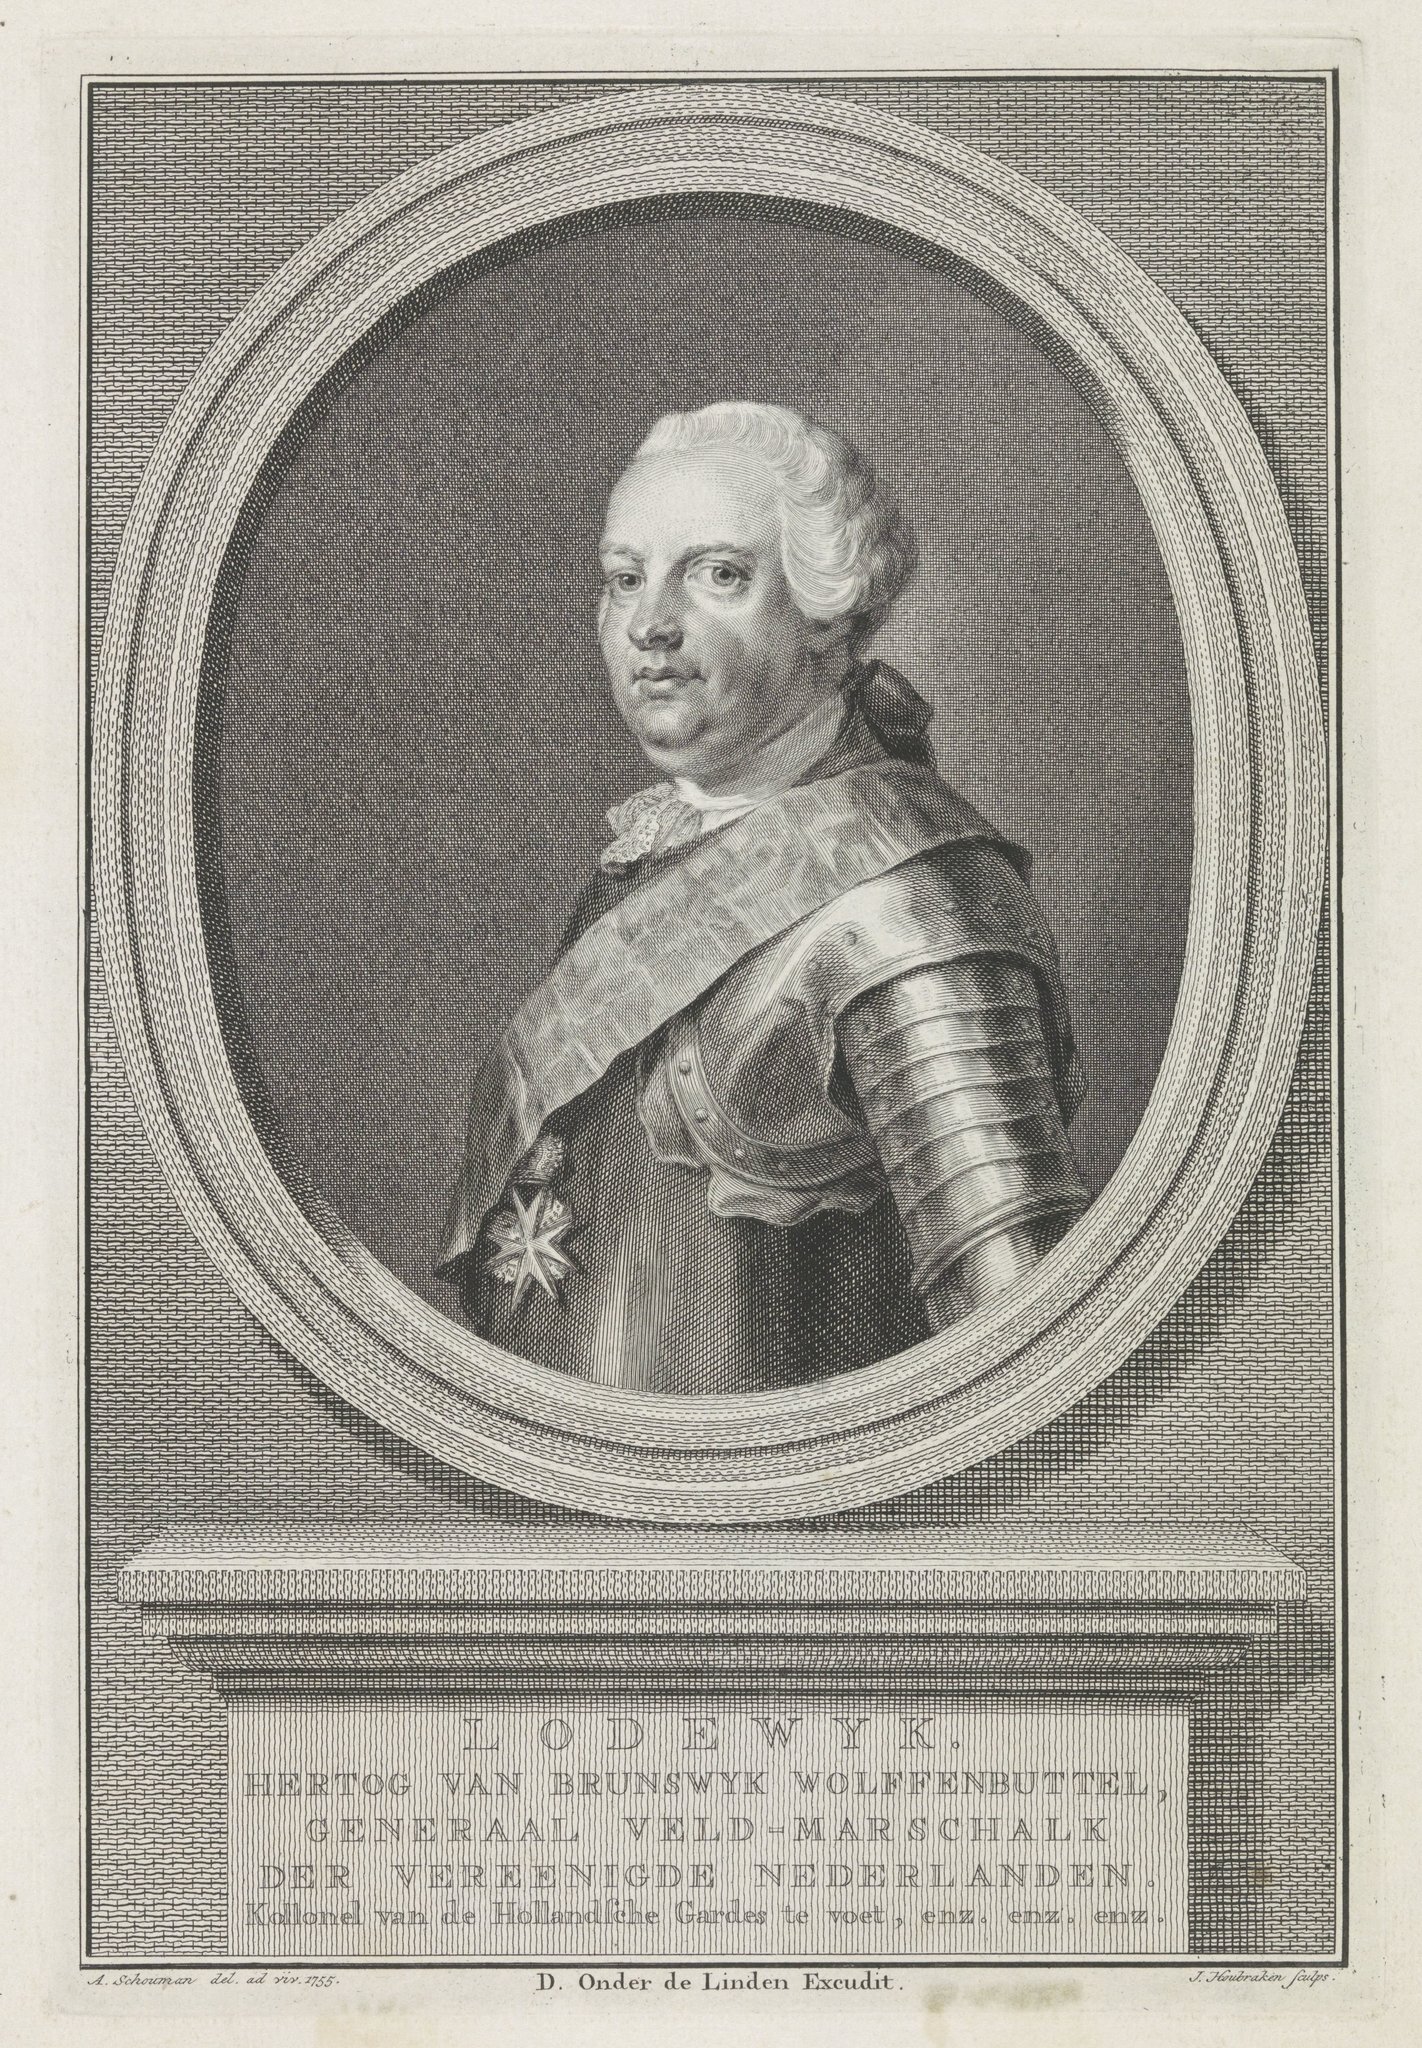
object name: print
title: Portret van Lodewijk van Brunswijk-Wolfenbüttel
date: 1755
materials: paper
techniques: engraving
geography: amsterdam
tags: ludwig ernst von braunschweig-wolfenbüttel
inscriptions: date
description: Portret van Lodewijk in een ovaal. In een kader zijn naam en titels.